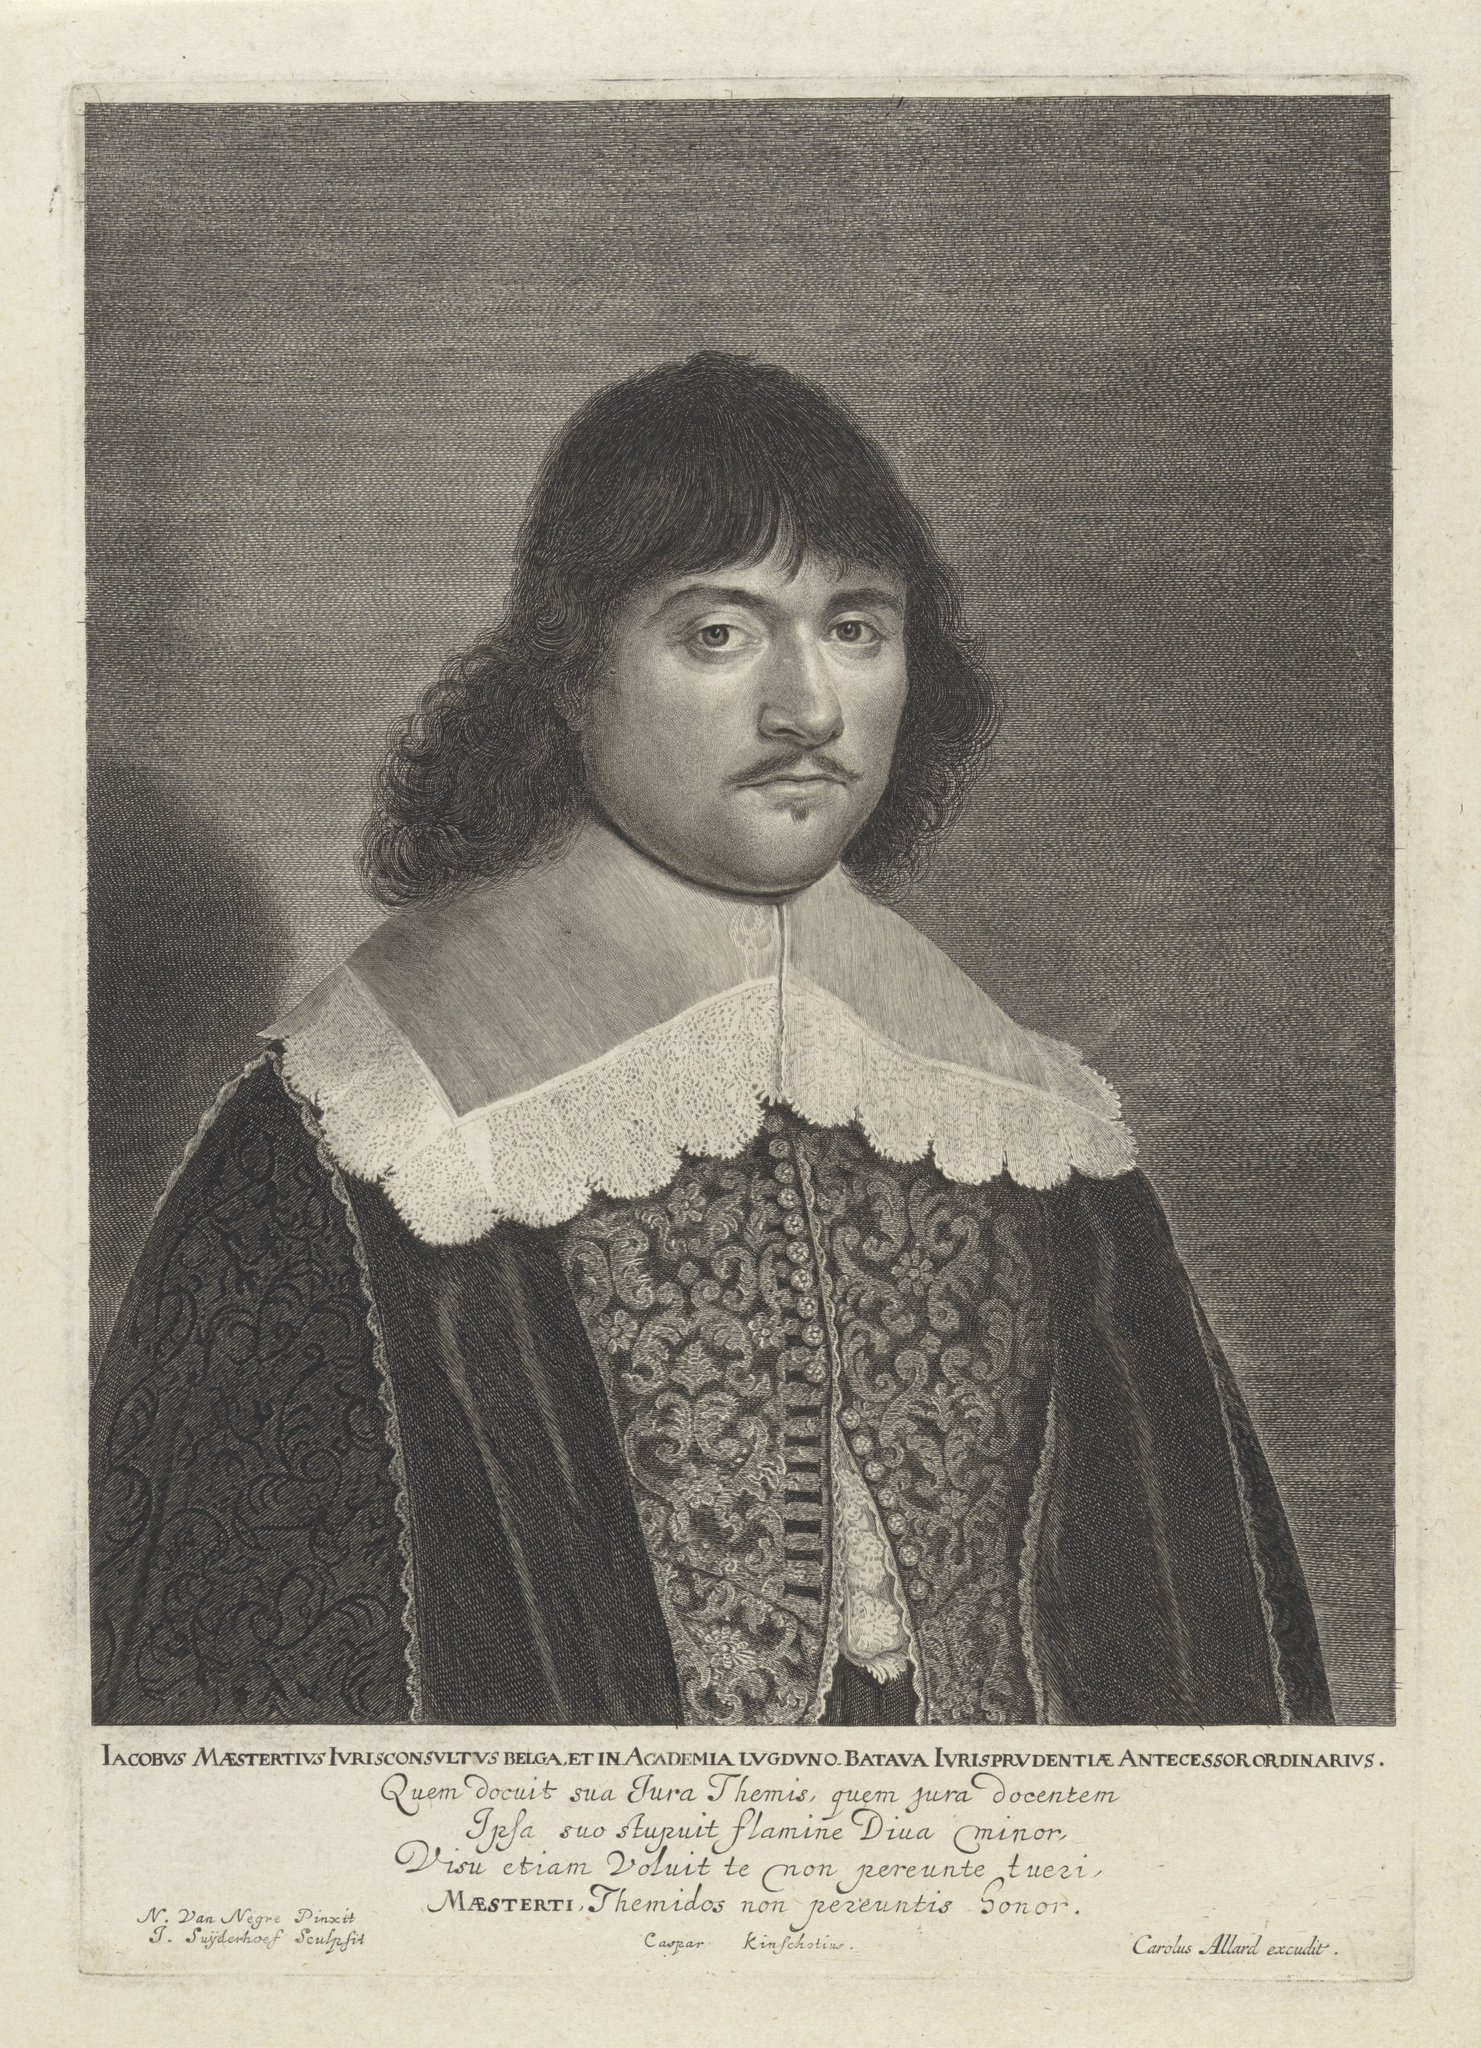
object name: print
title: Portret van Jacob Maestert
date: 1673-1709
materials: paper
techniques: engraving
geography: amsterdam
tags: professor (+ portrait of teacher, professor)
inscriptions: collector's mark: Lugt 2228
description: Portret van Jacob Maestert, hoogleraar rechten aan de universiteit van Leiden. Onderaan in de marge een vierregelig vers in het Latijn.